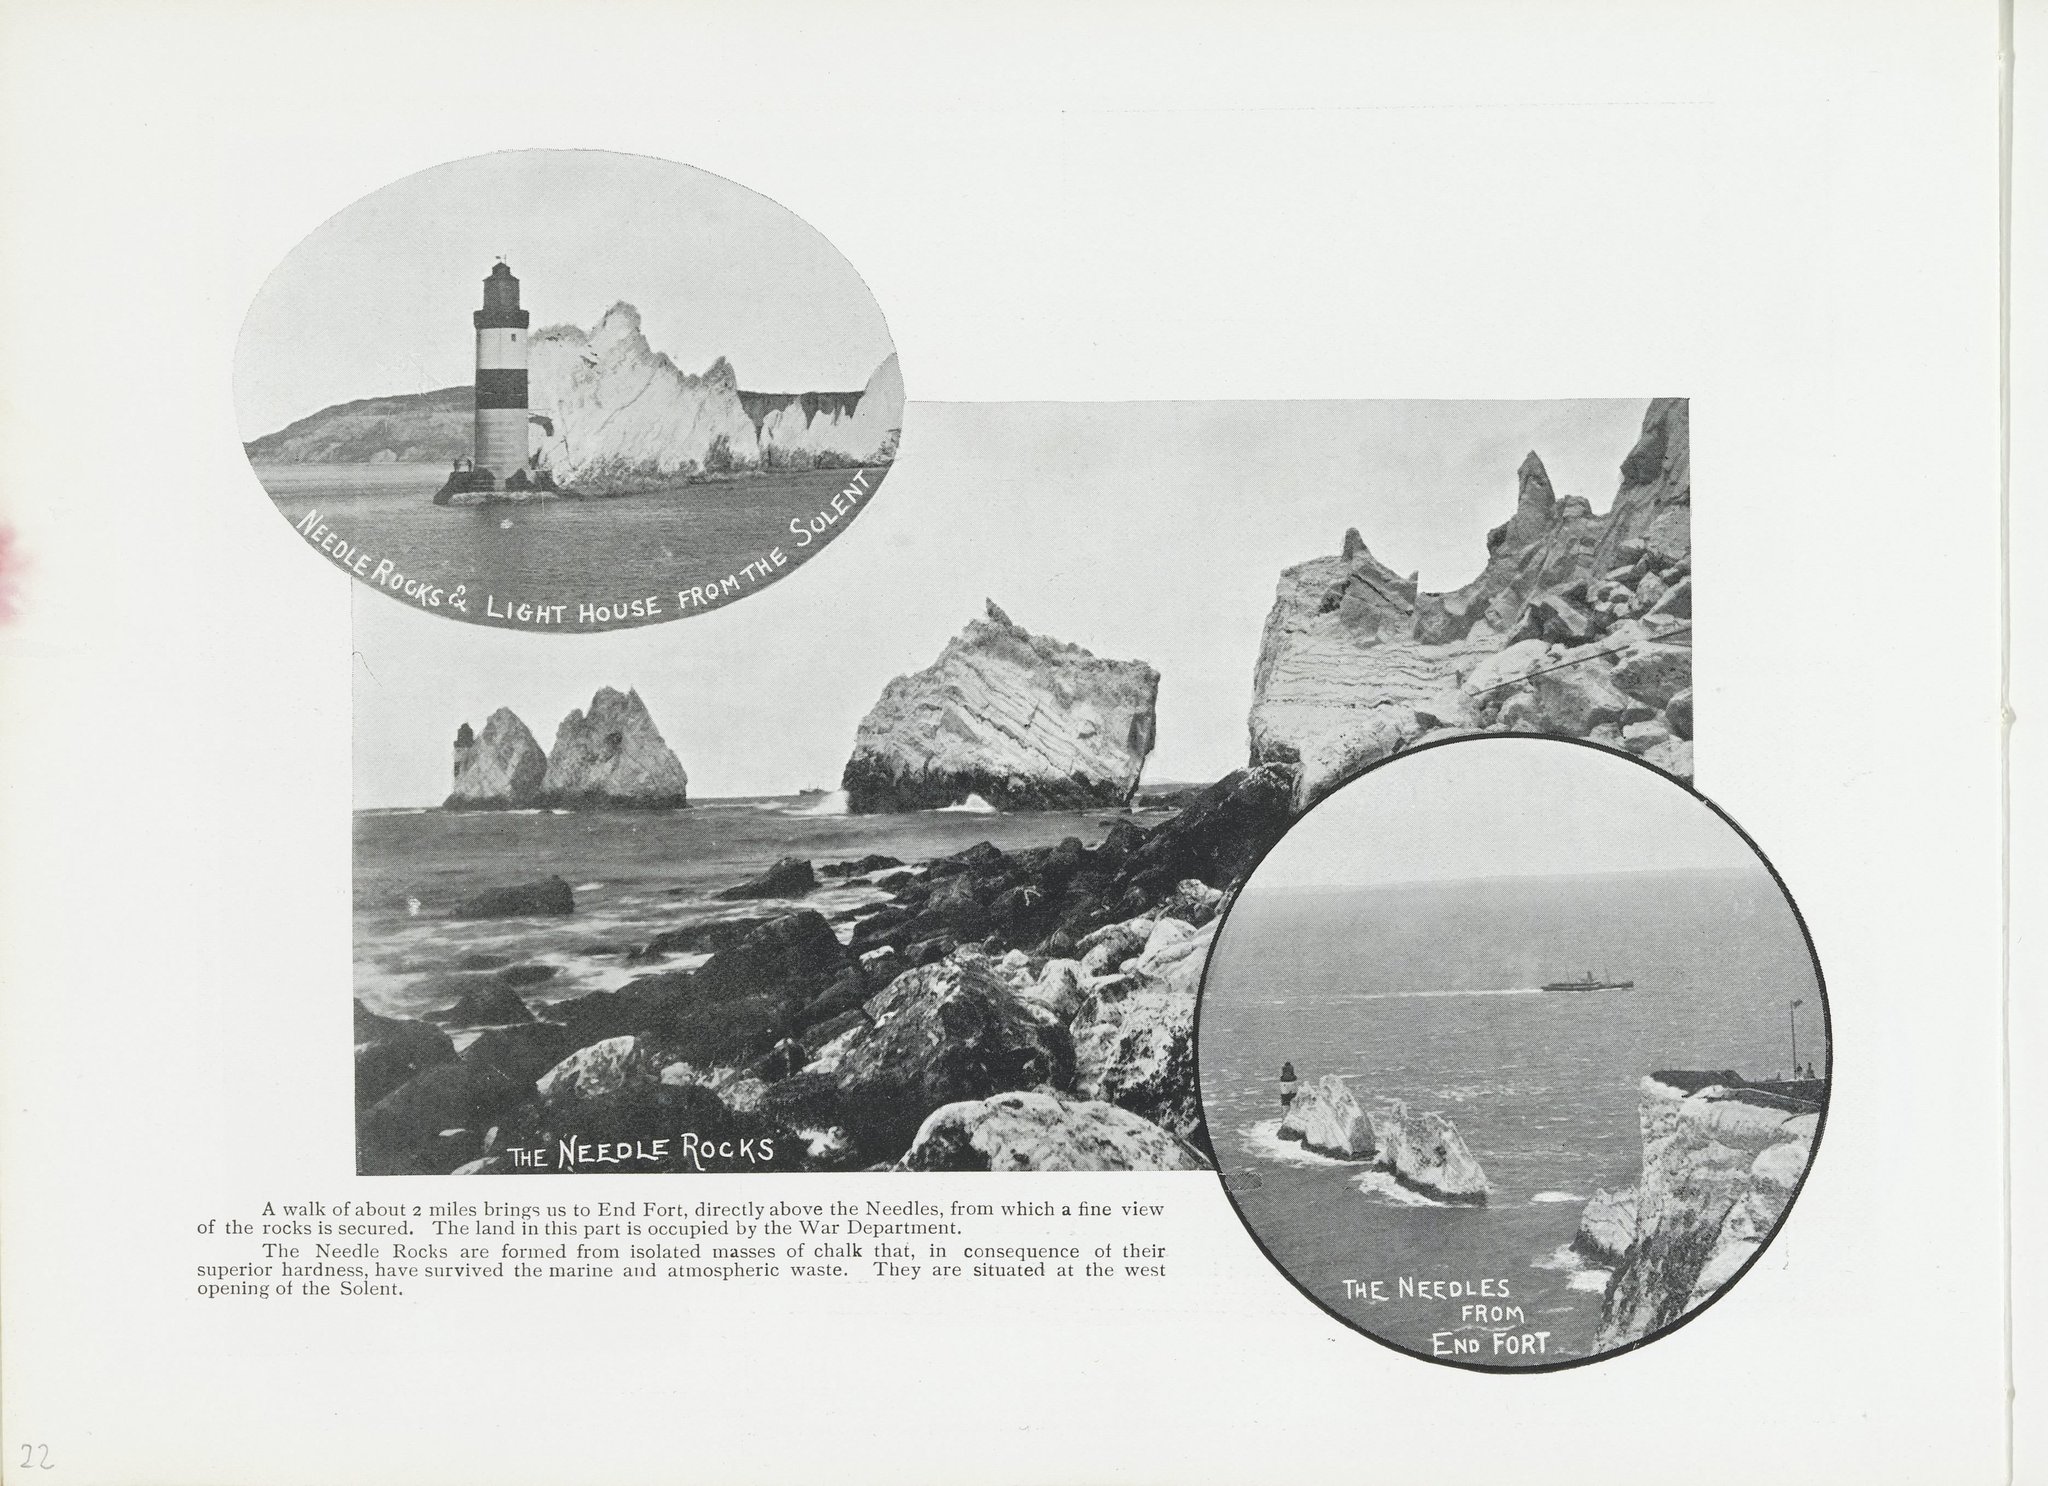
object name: page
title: The Needle Rocks (The Needles)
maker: Anonymous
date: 1897-1930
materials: paper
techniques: printing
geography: isle of wight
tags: lighthouse, lightship, landscapes with waters, waterscapes, seascapes (in the temperate zone), travelling; tourism, rock-formations, coastal cliff or crag, isle of wight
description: Pagina 22 met 3 foto's van The Needle Rocks en de vuurtoren op de westelijke punt van het Isle of Wight en een bijschrift. Onderdeel van Fotografische reisreportage van het eiland Wight.